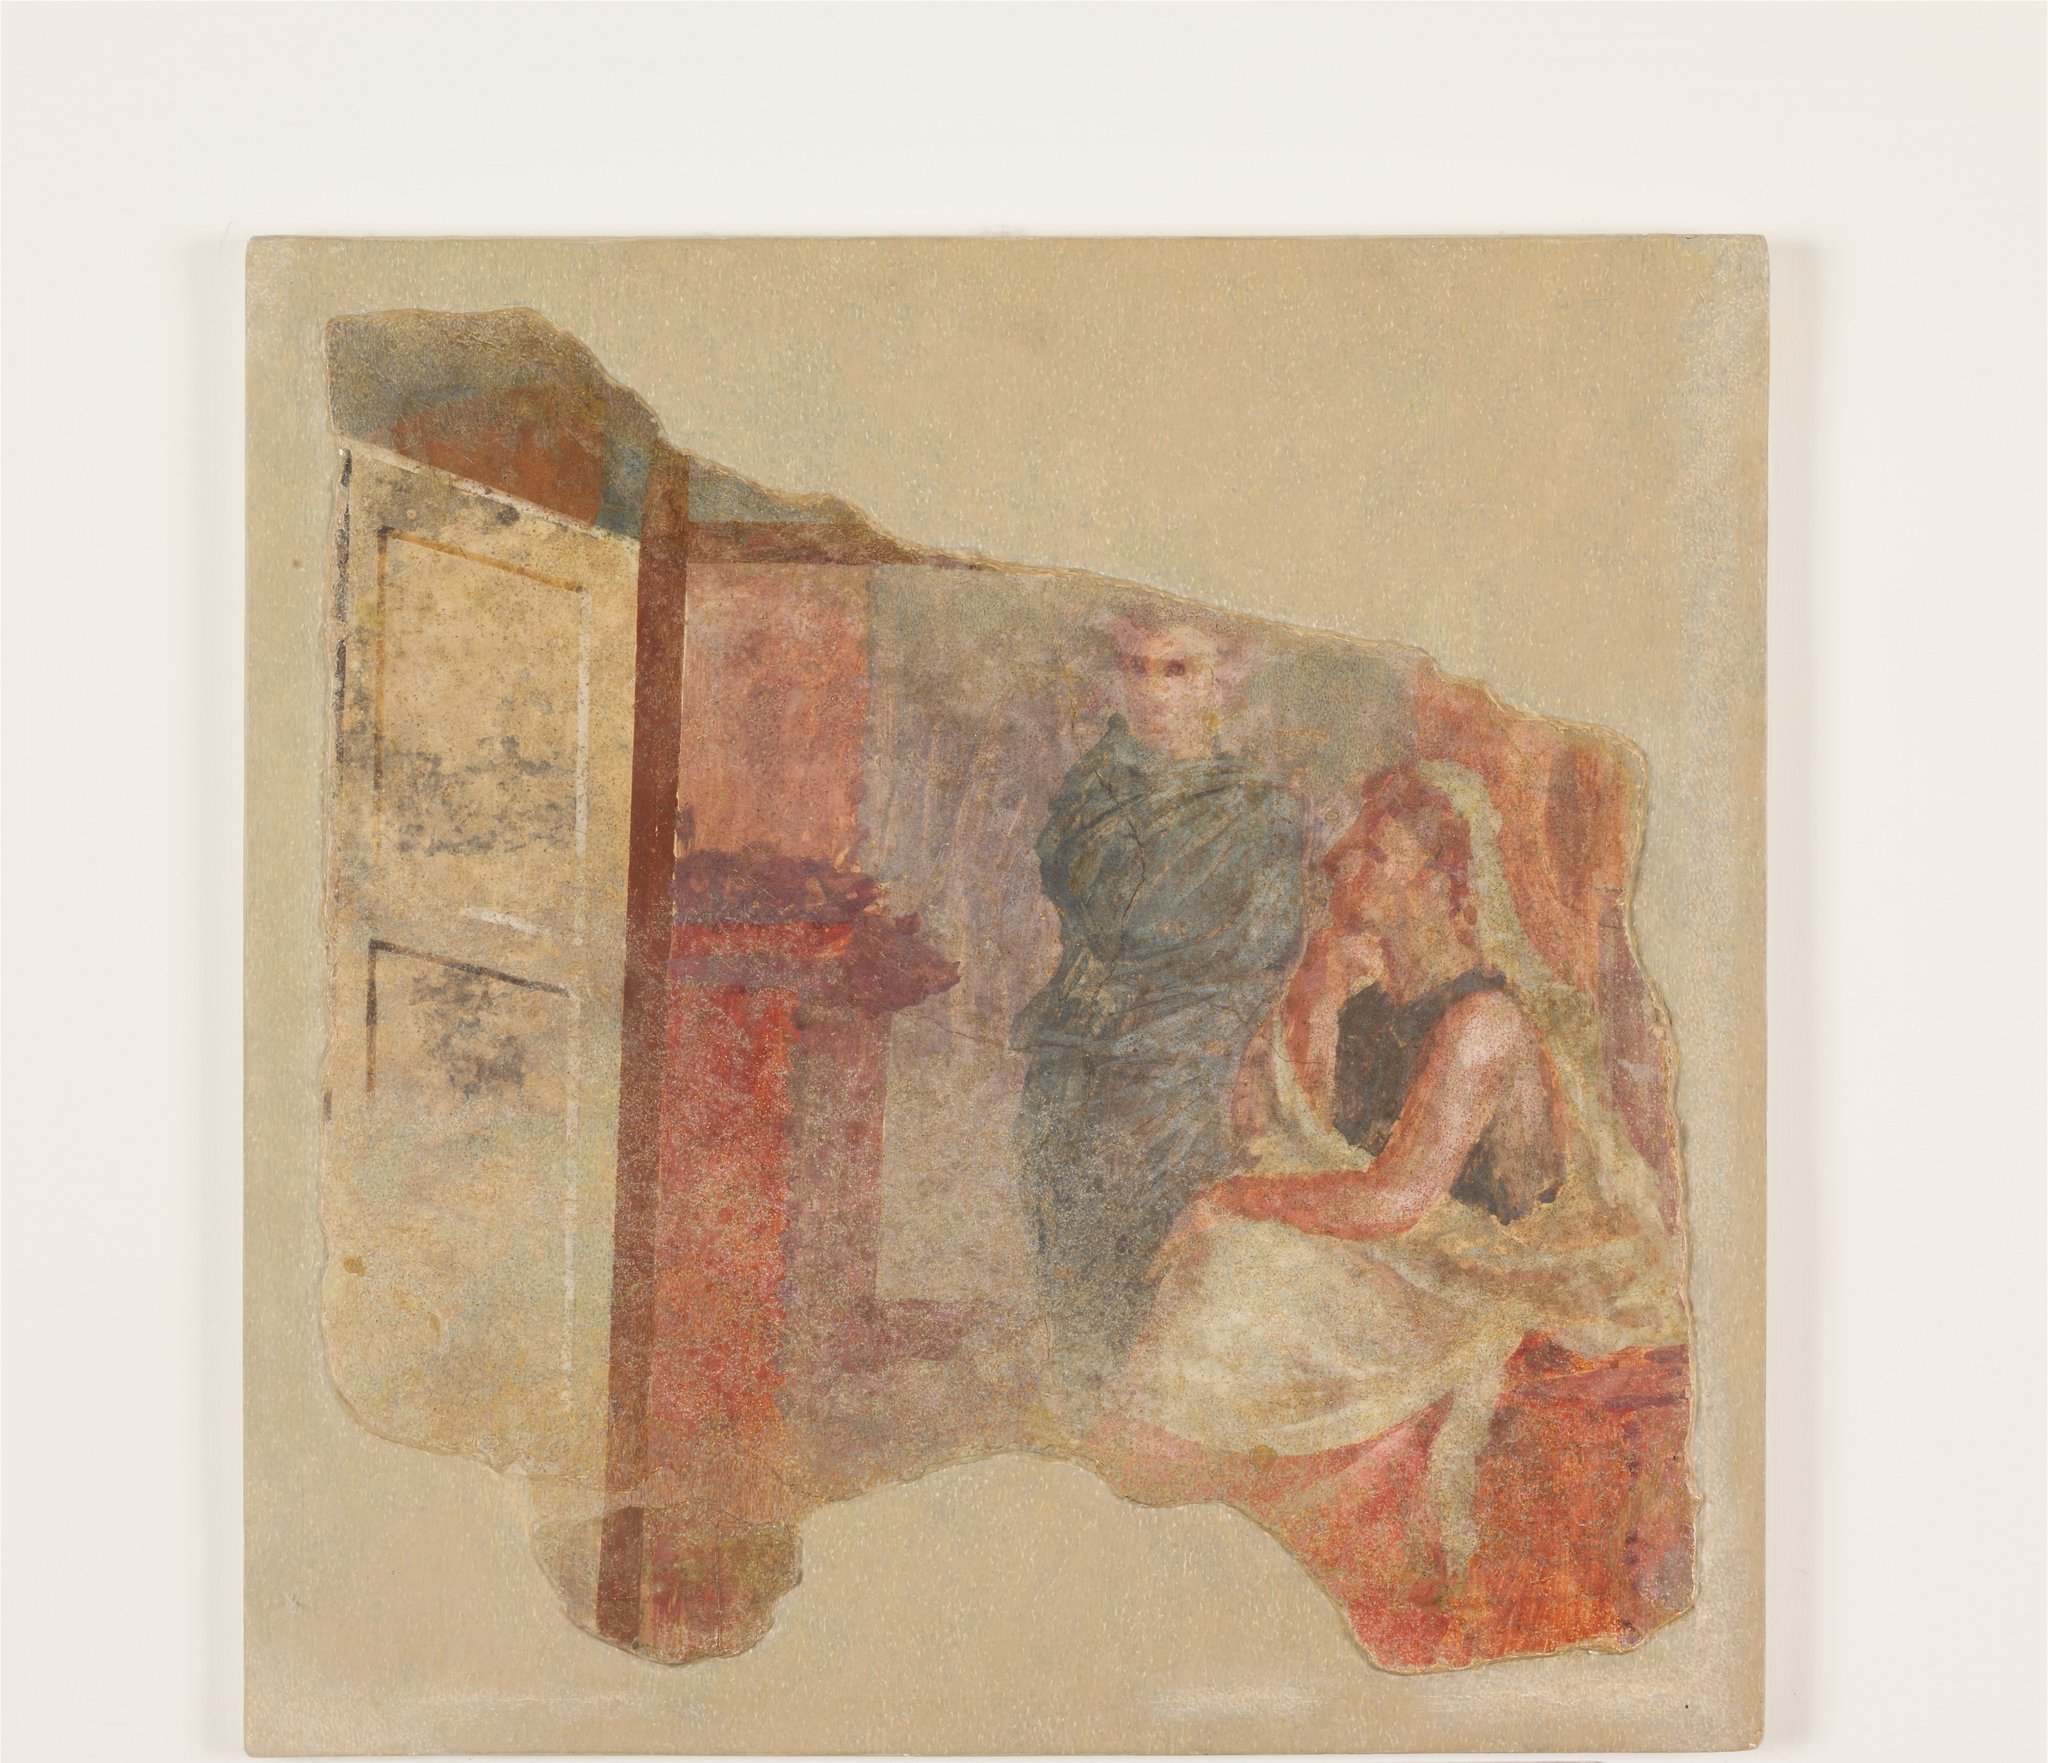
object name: wall painting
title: Wall painting fragment from the north wall of Room H of the Villa of P. Fannius Synistor at Boscoreale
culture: roman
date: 50-40 BCE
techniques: fresco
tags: men,women